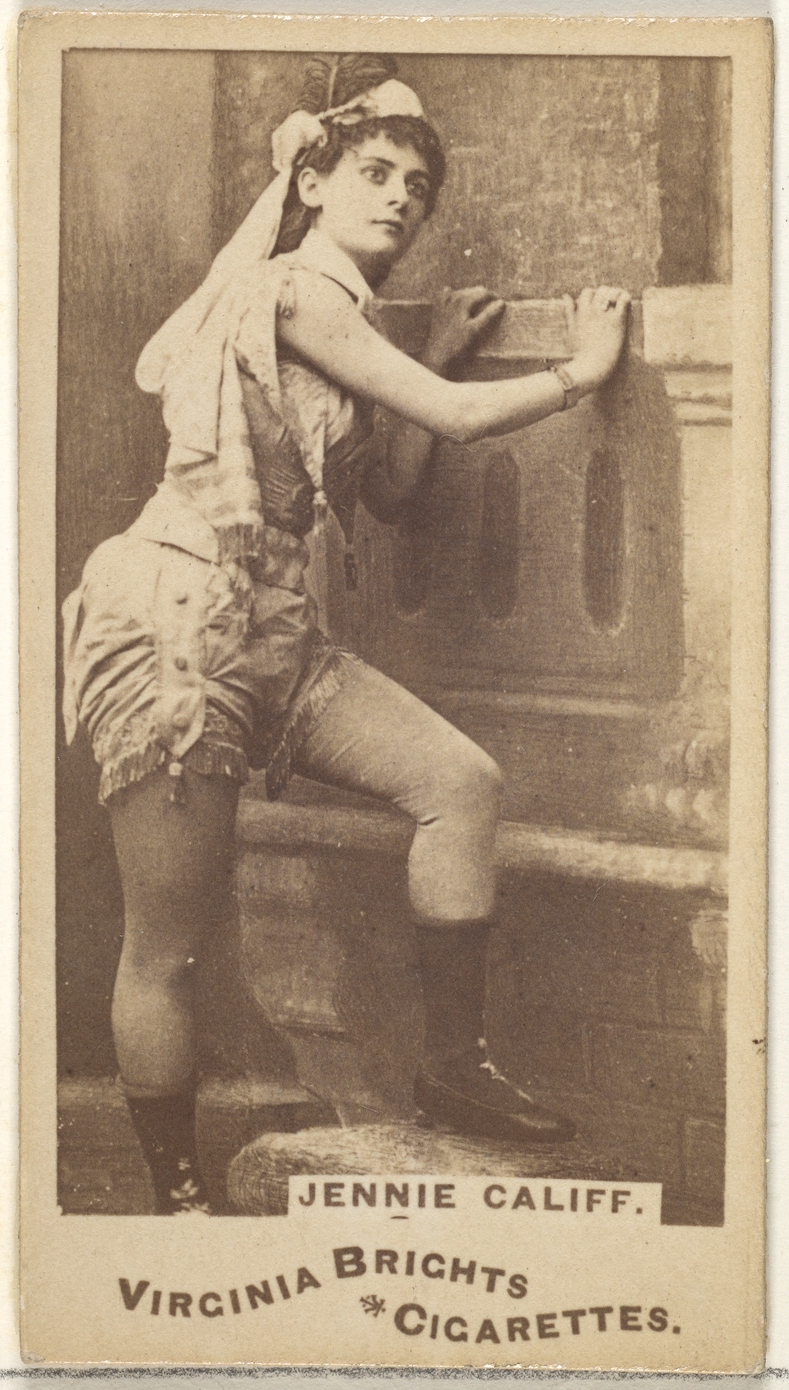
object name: photograph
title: Jennie Califf, from the Actors and Actresses series (N45, Type 1) for Virginia Brights Cigarettes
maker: allen & ginter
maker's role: publisher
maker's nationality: american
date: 1888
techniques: albumen silver print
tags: portraits,women,actresses